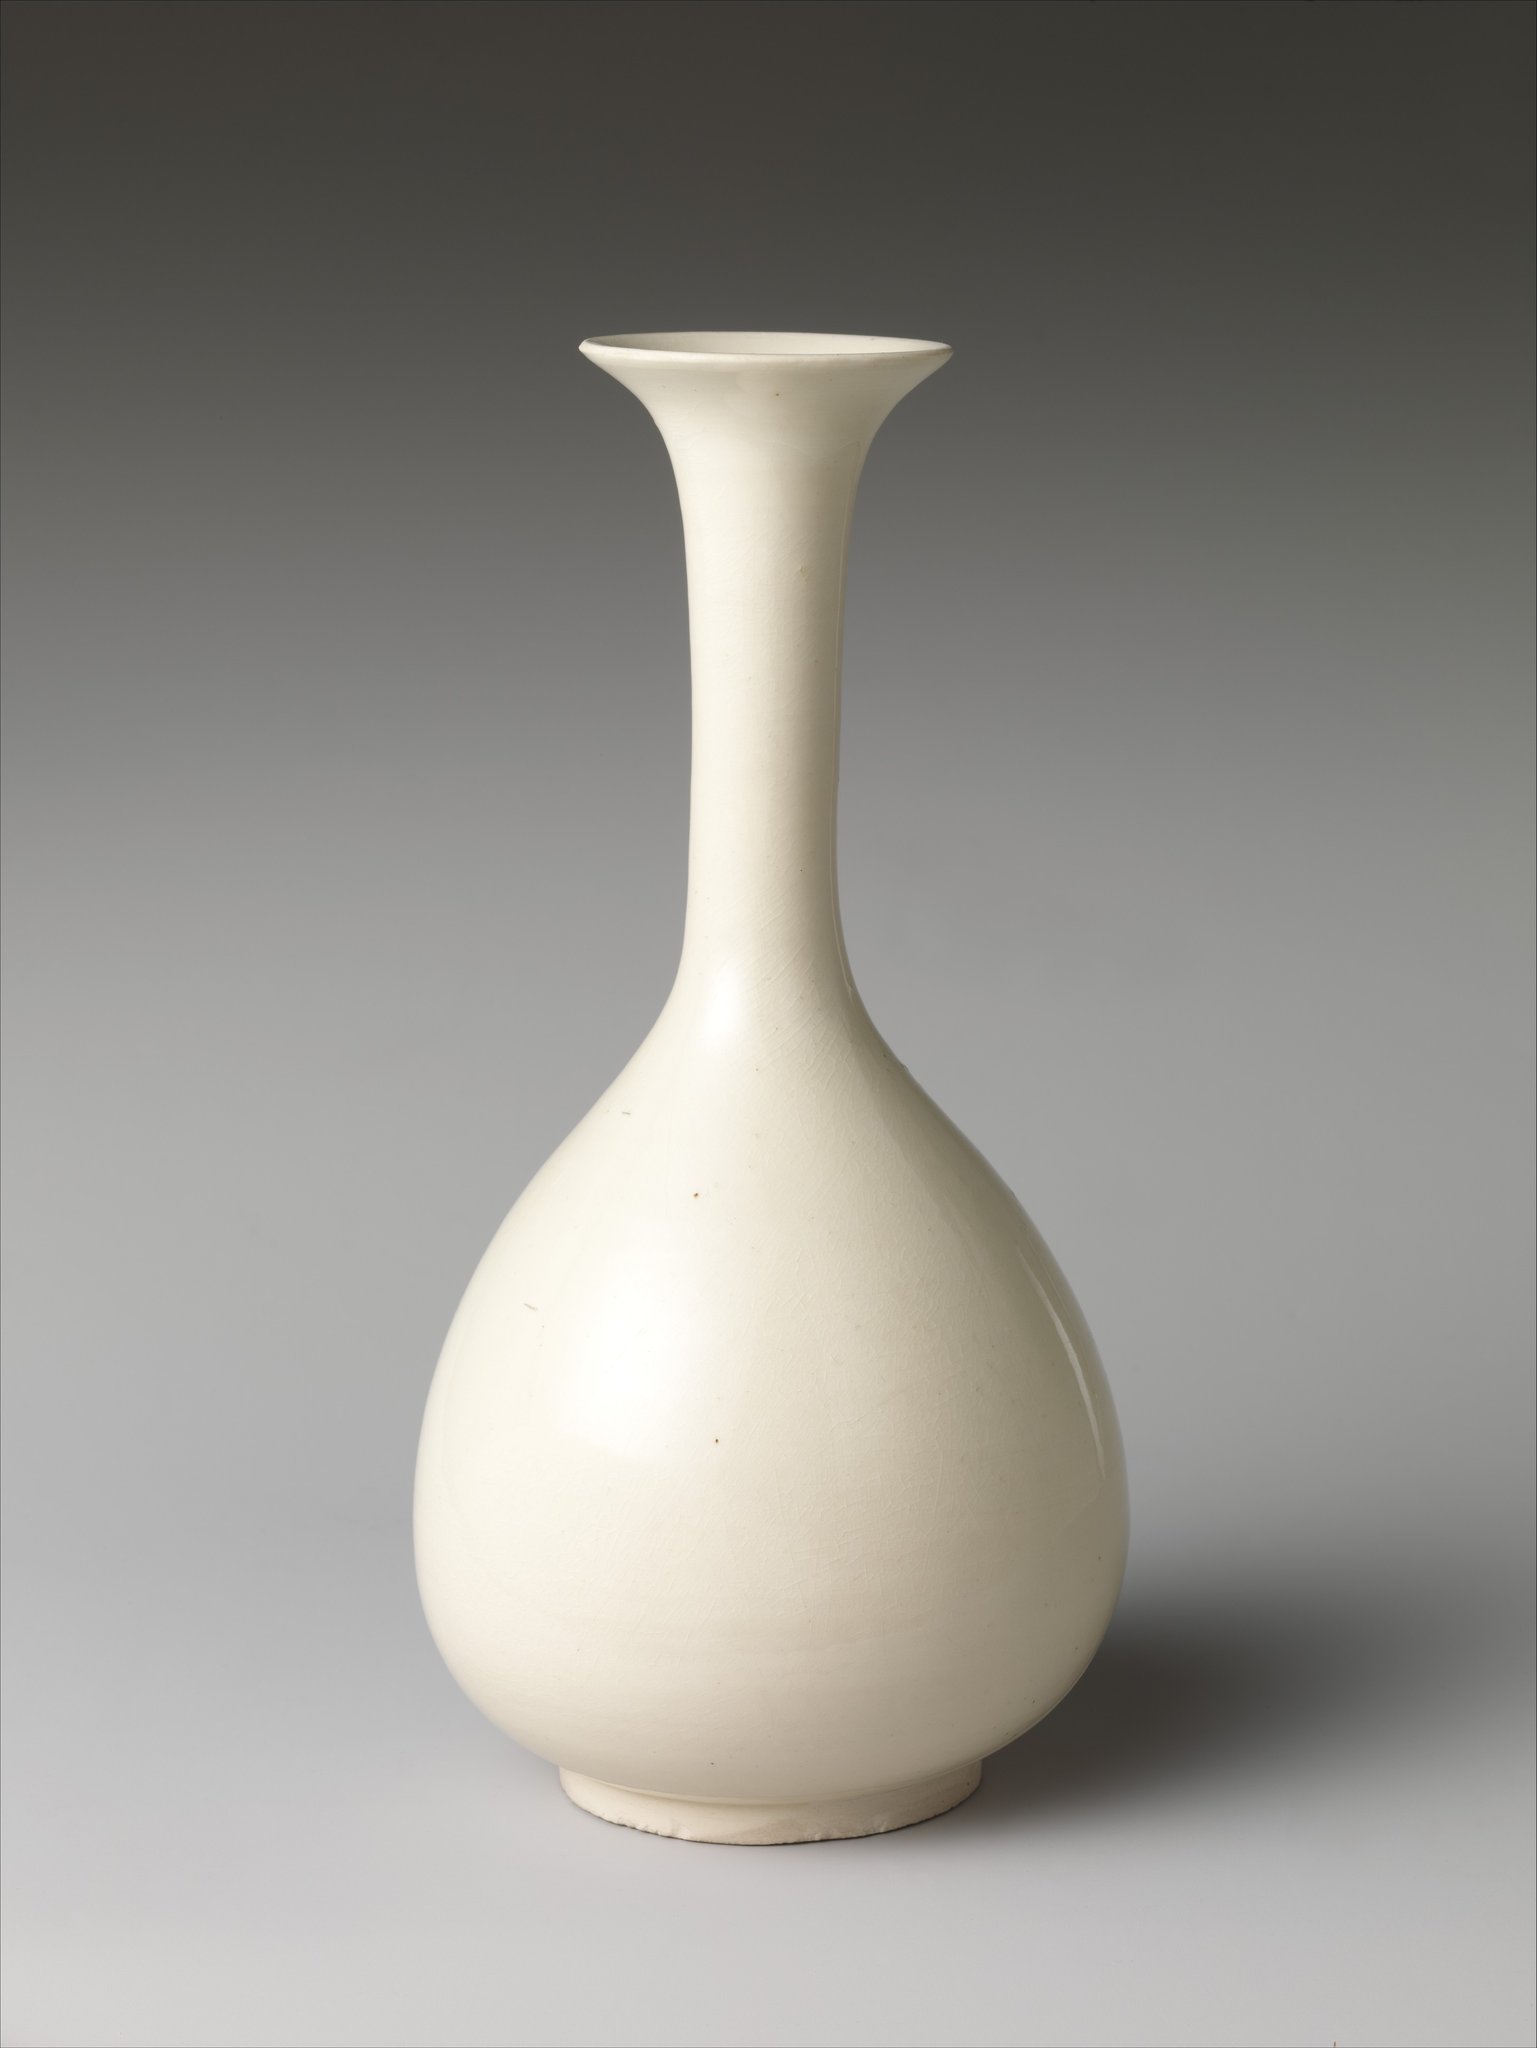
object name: bottle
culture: chinese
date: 1001-1200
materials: glaze, ivory, porcelain